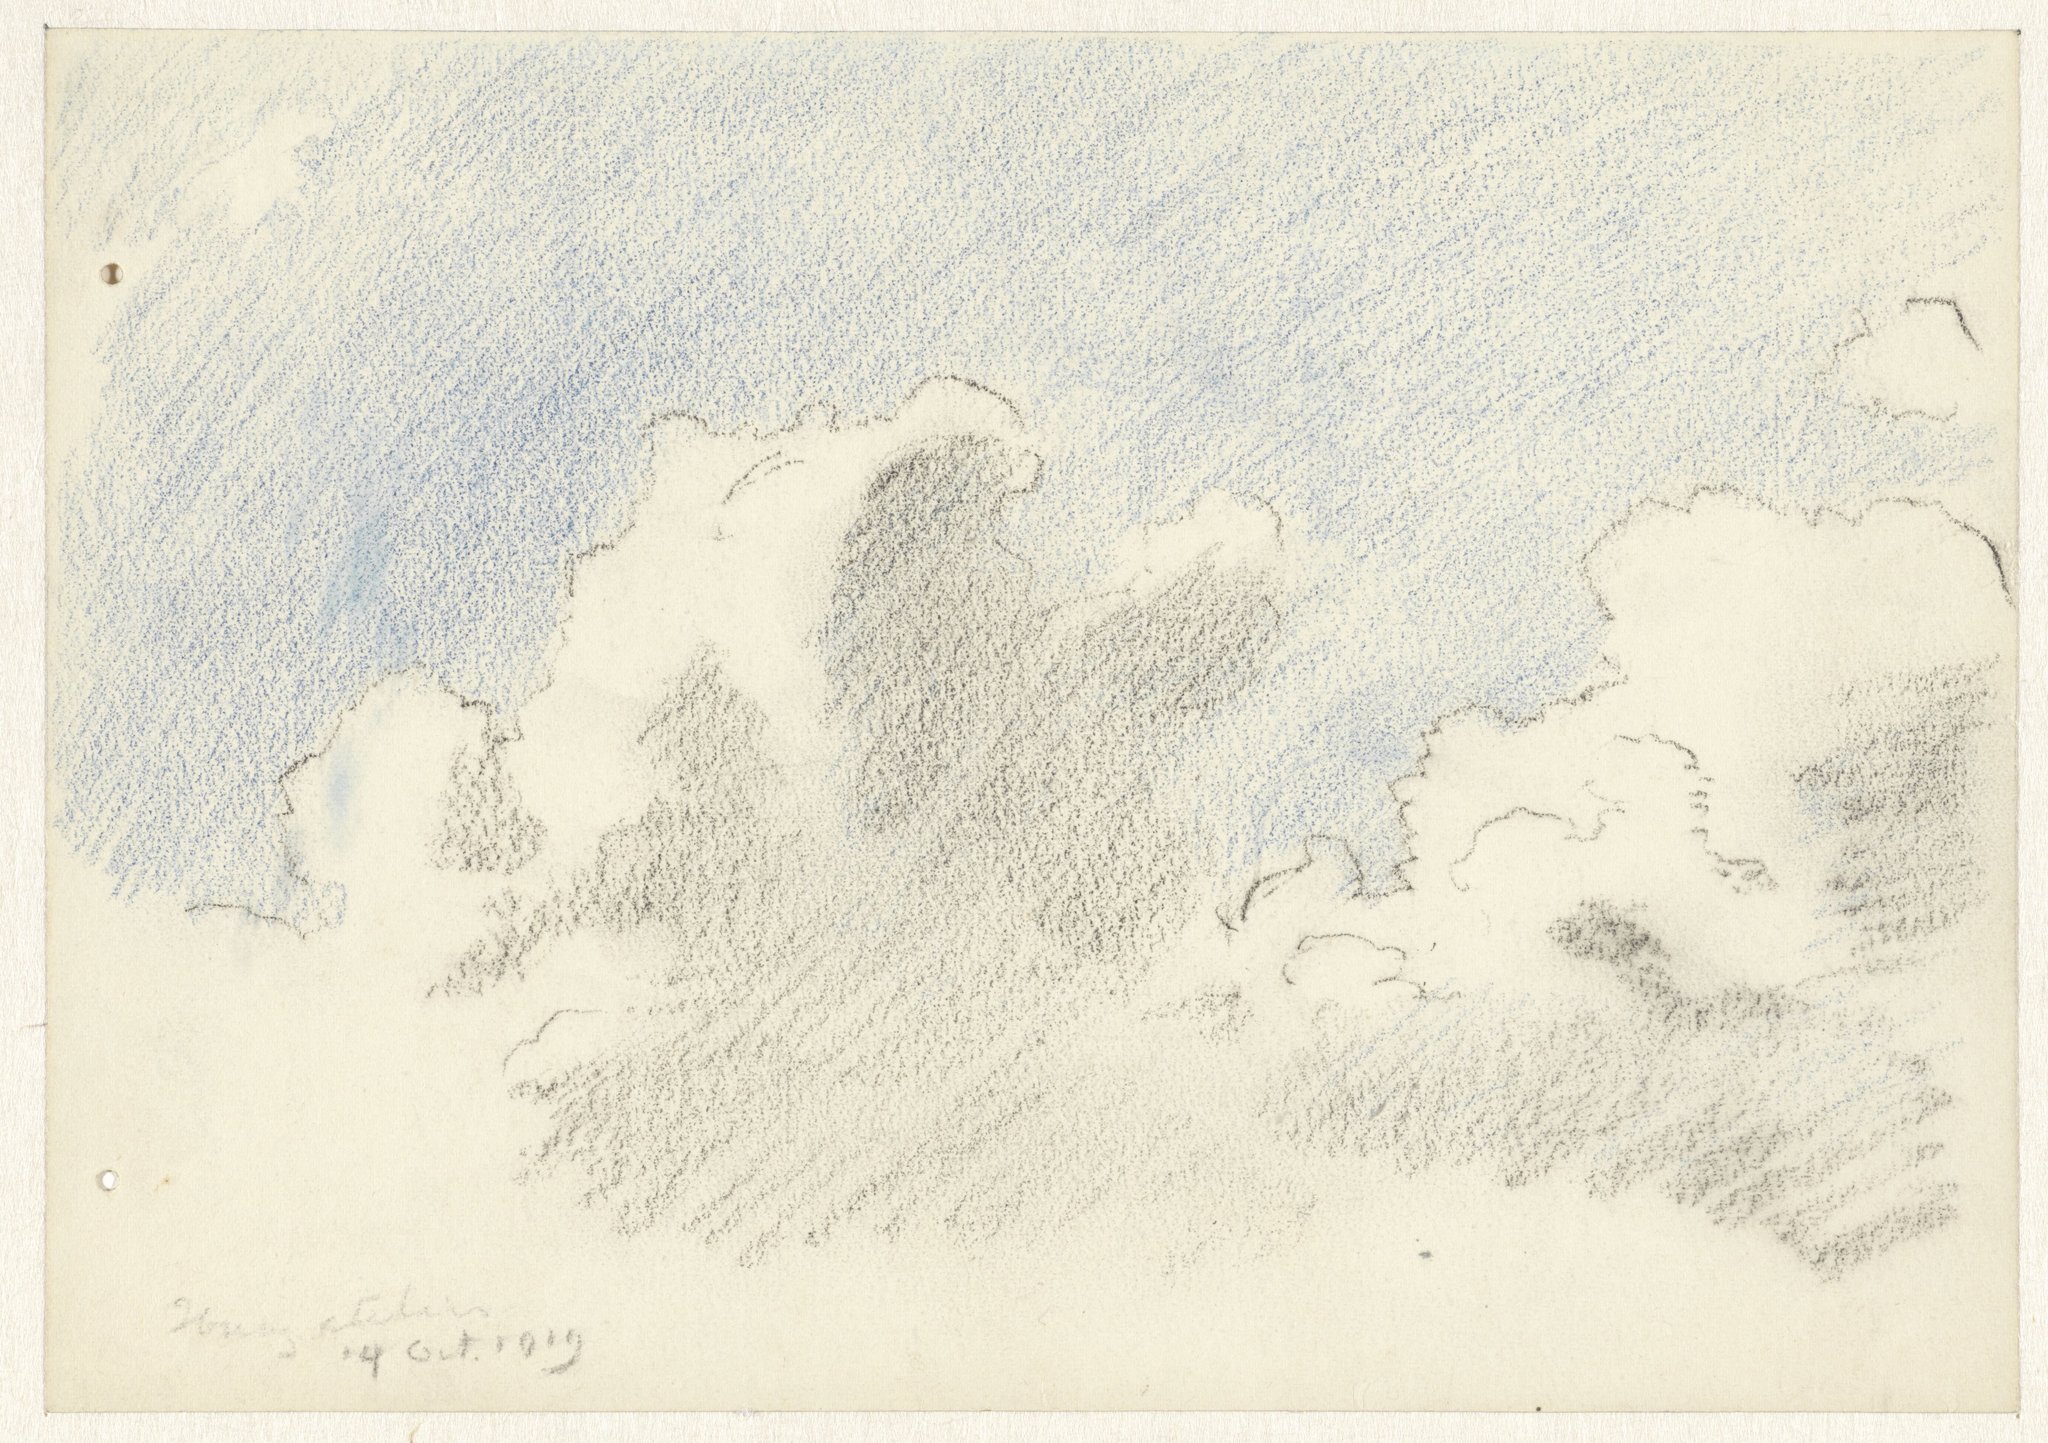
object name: drawing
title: Wolkenstudie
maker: adolf le comte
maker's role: draughtsman, painter, print maker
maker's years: 1850-1921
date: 1919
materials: chalk, paper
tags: clouds